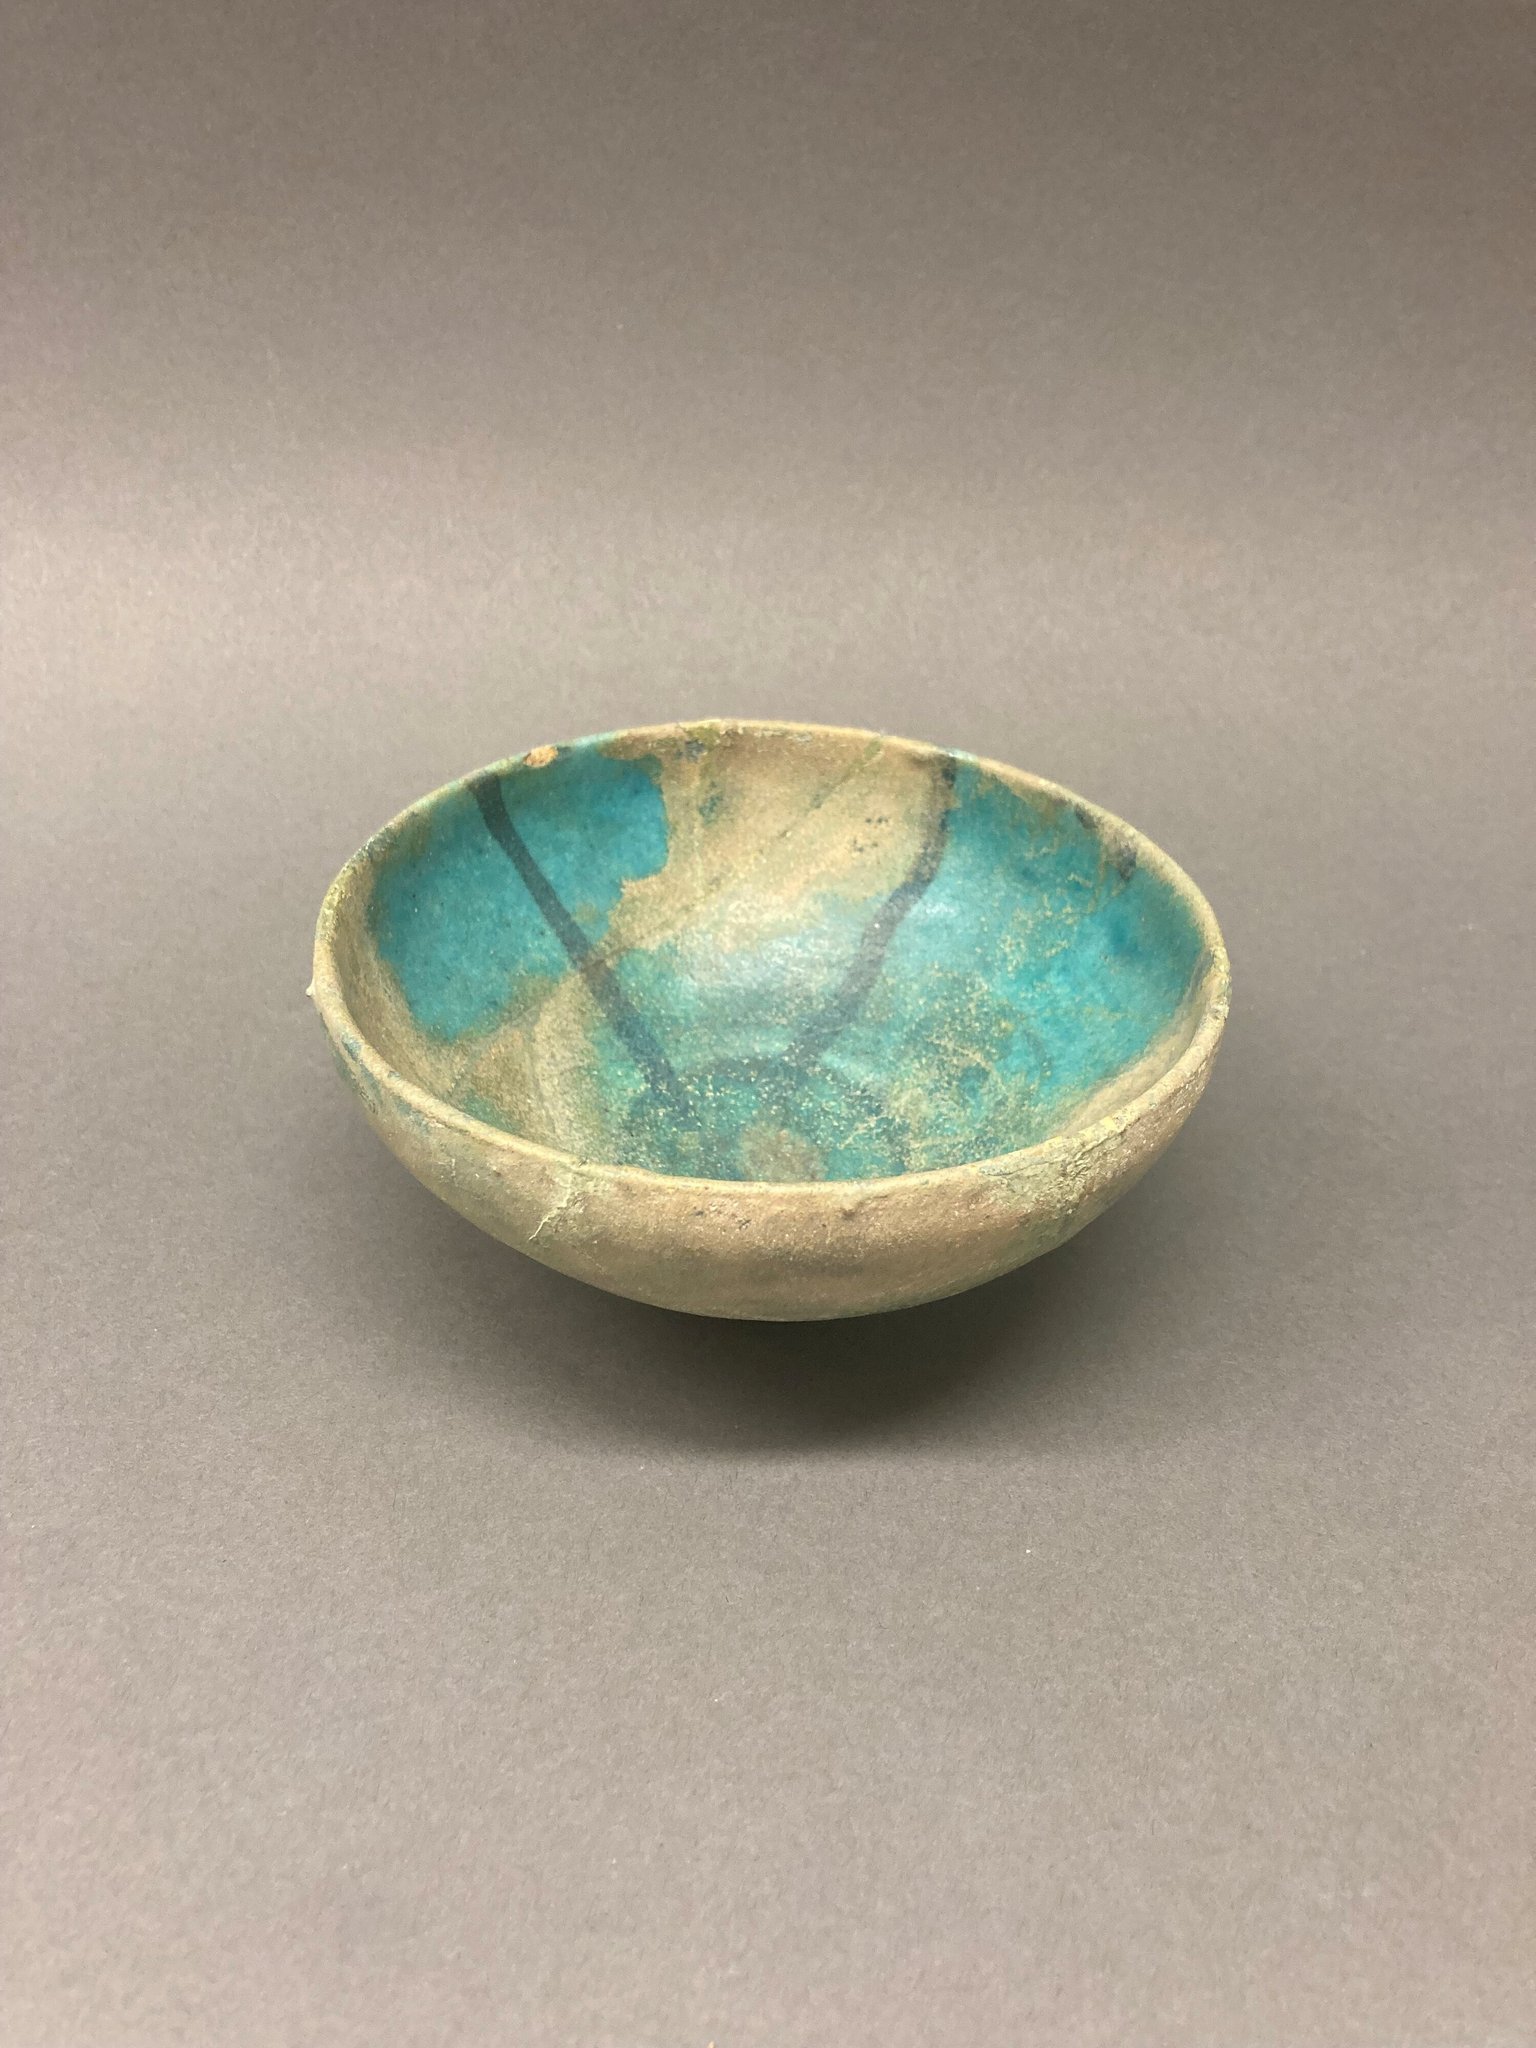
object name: bowl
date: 1001-1100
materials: earthenware, glaze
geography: iran